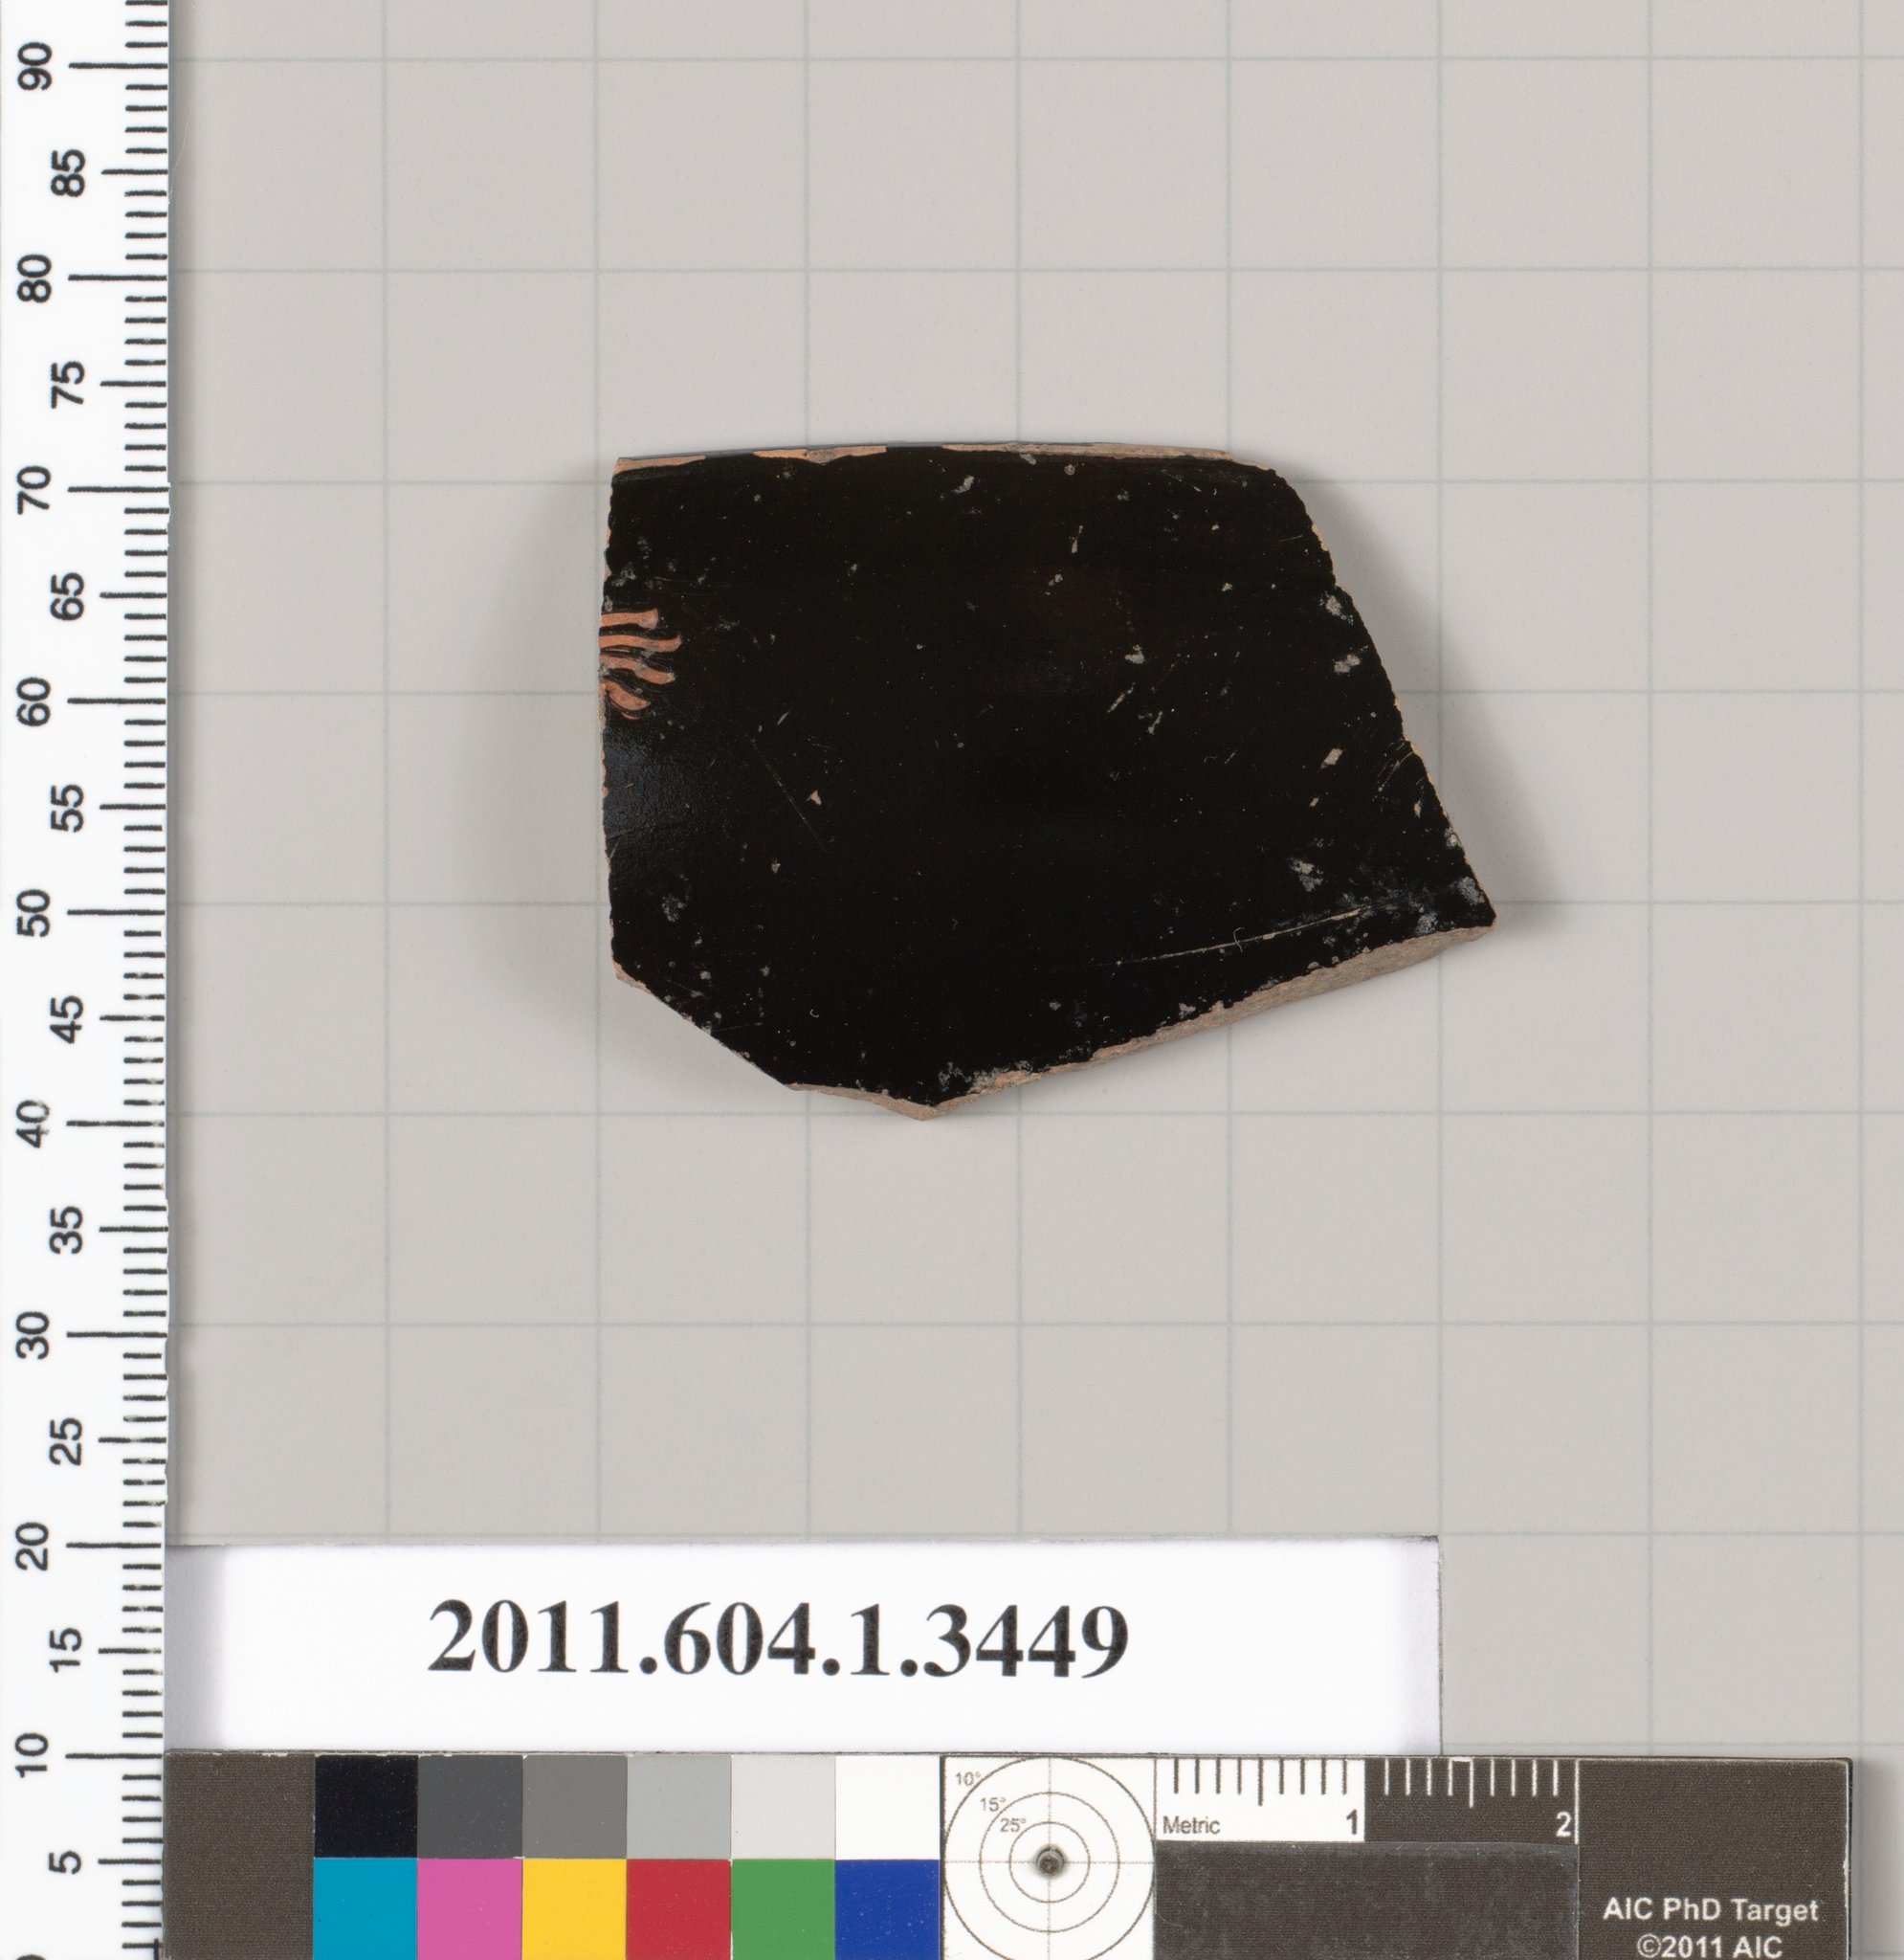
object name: kylix fragment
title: Terracotta rim fragment of a kylix (drinking cup)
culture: greek, attic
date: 500-475 BCE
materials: terracotta